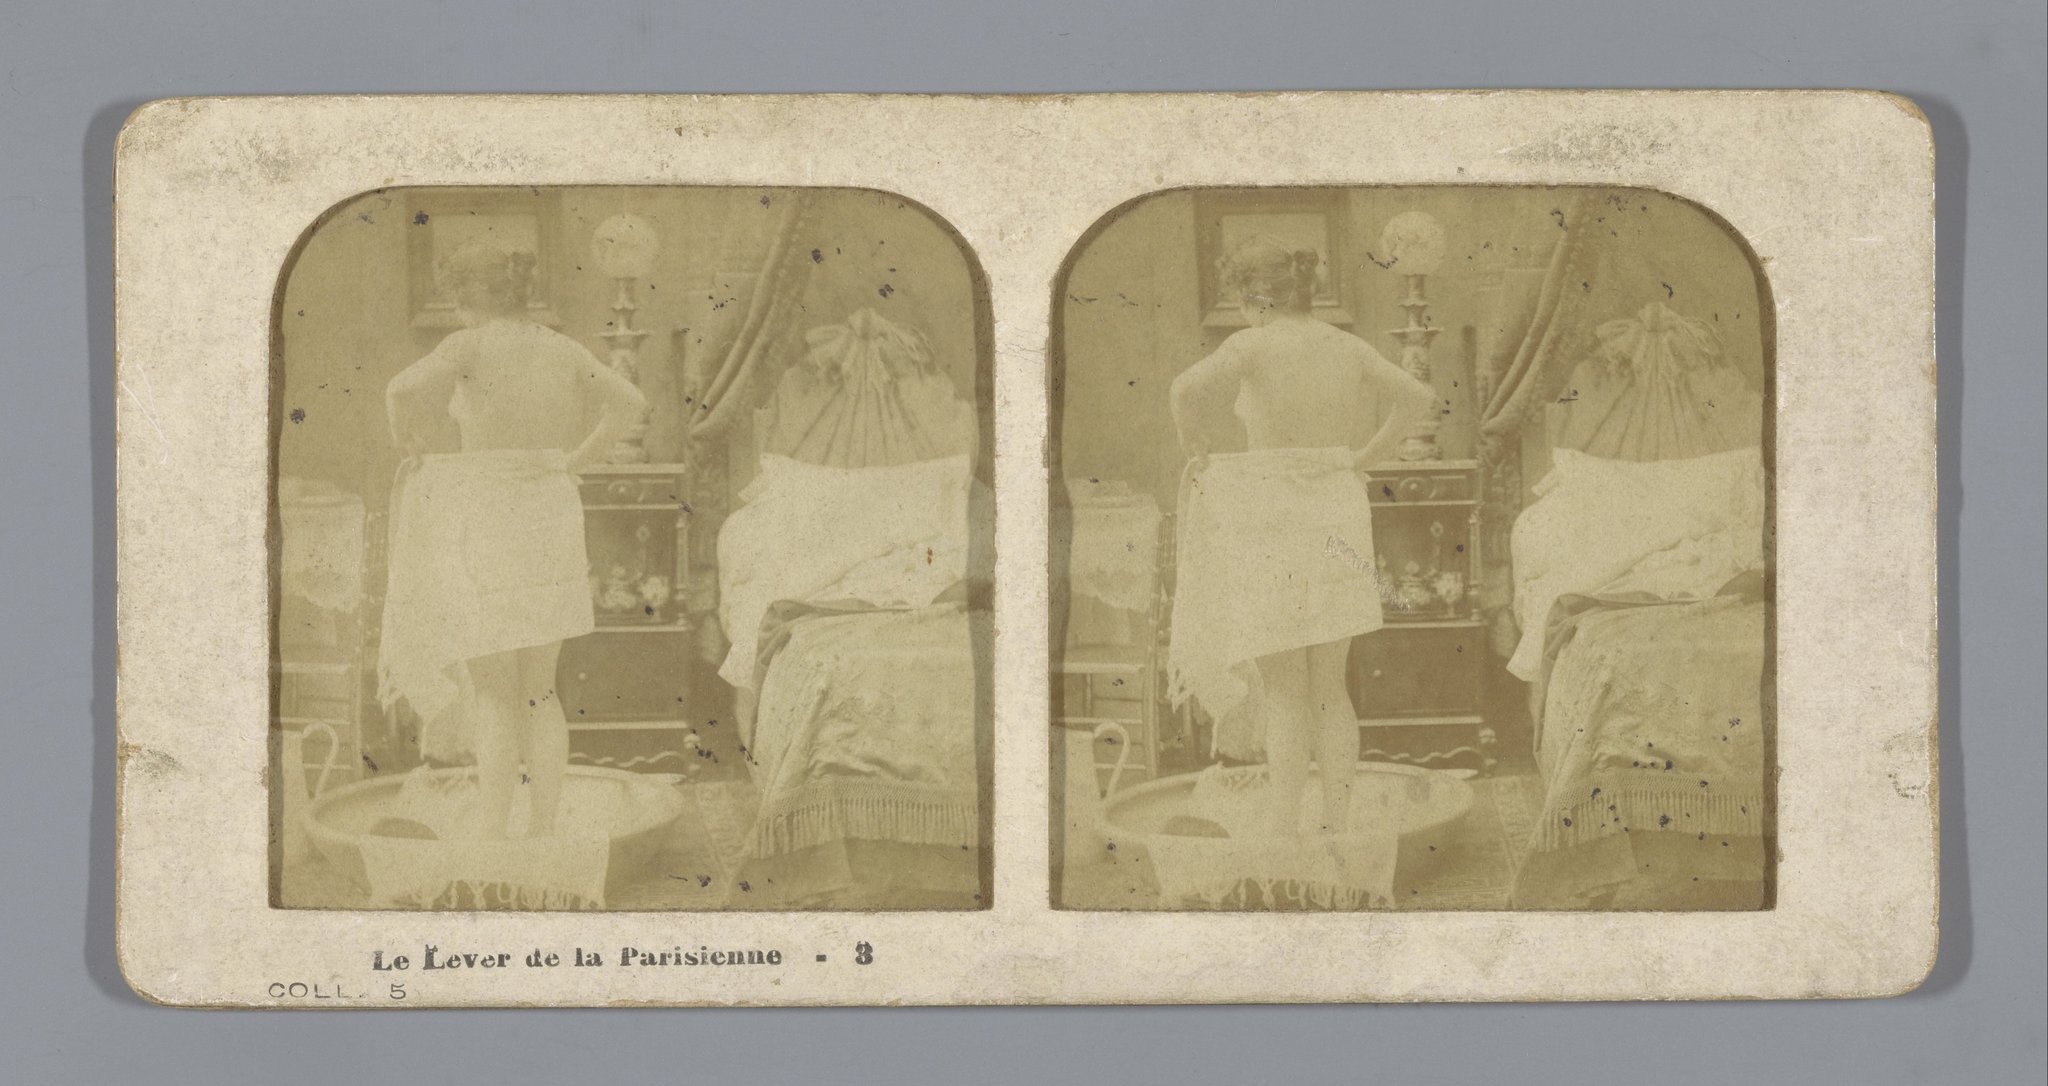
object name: stereograph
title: Le lever de la Parisienne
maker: Anonymous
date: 1855-1905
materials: cardboard, paper, photographic support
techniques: albumen print, hand coloring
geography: paris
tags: washing and bathing, paris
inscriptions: number: ‘3’, inscription: ‘COLL. 5’